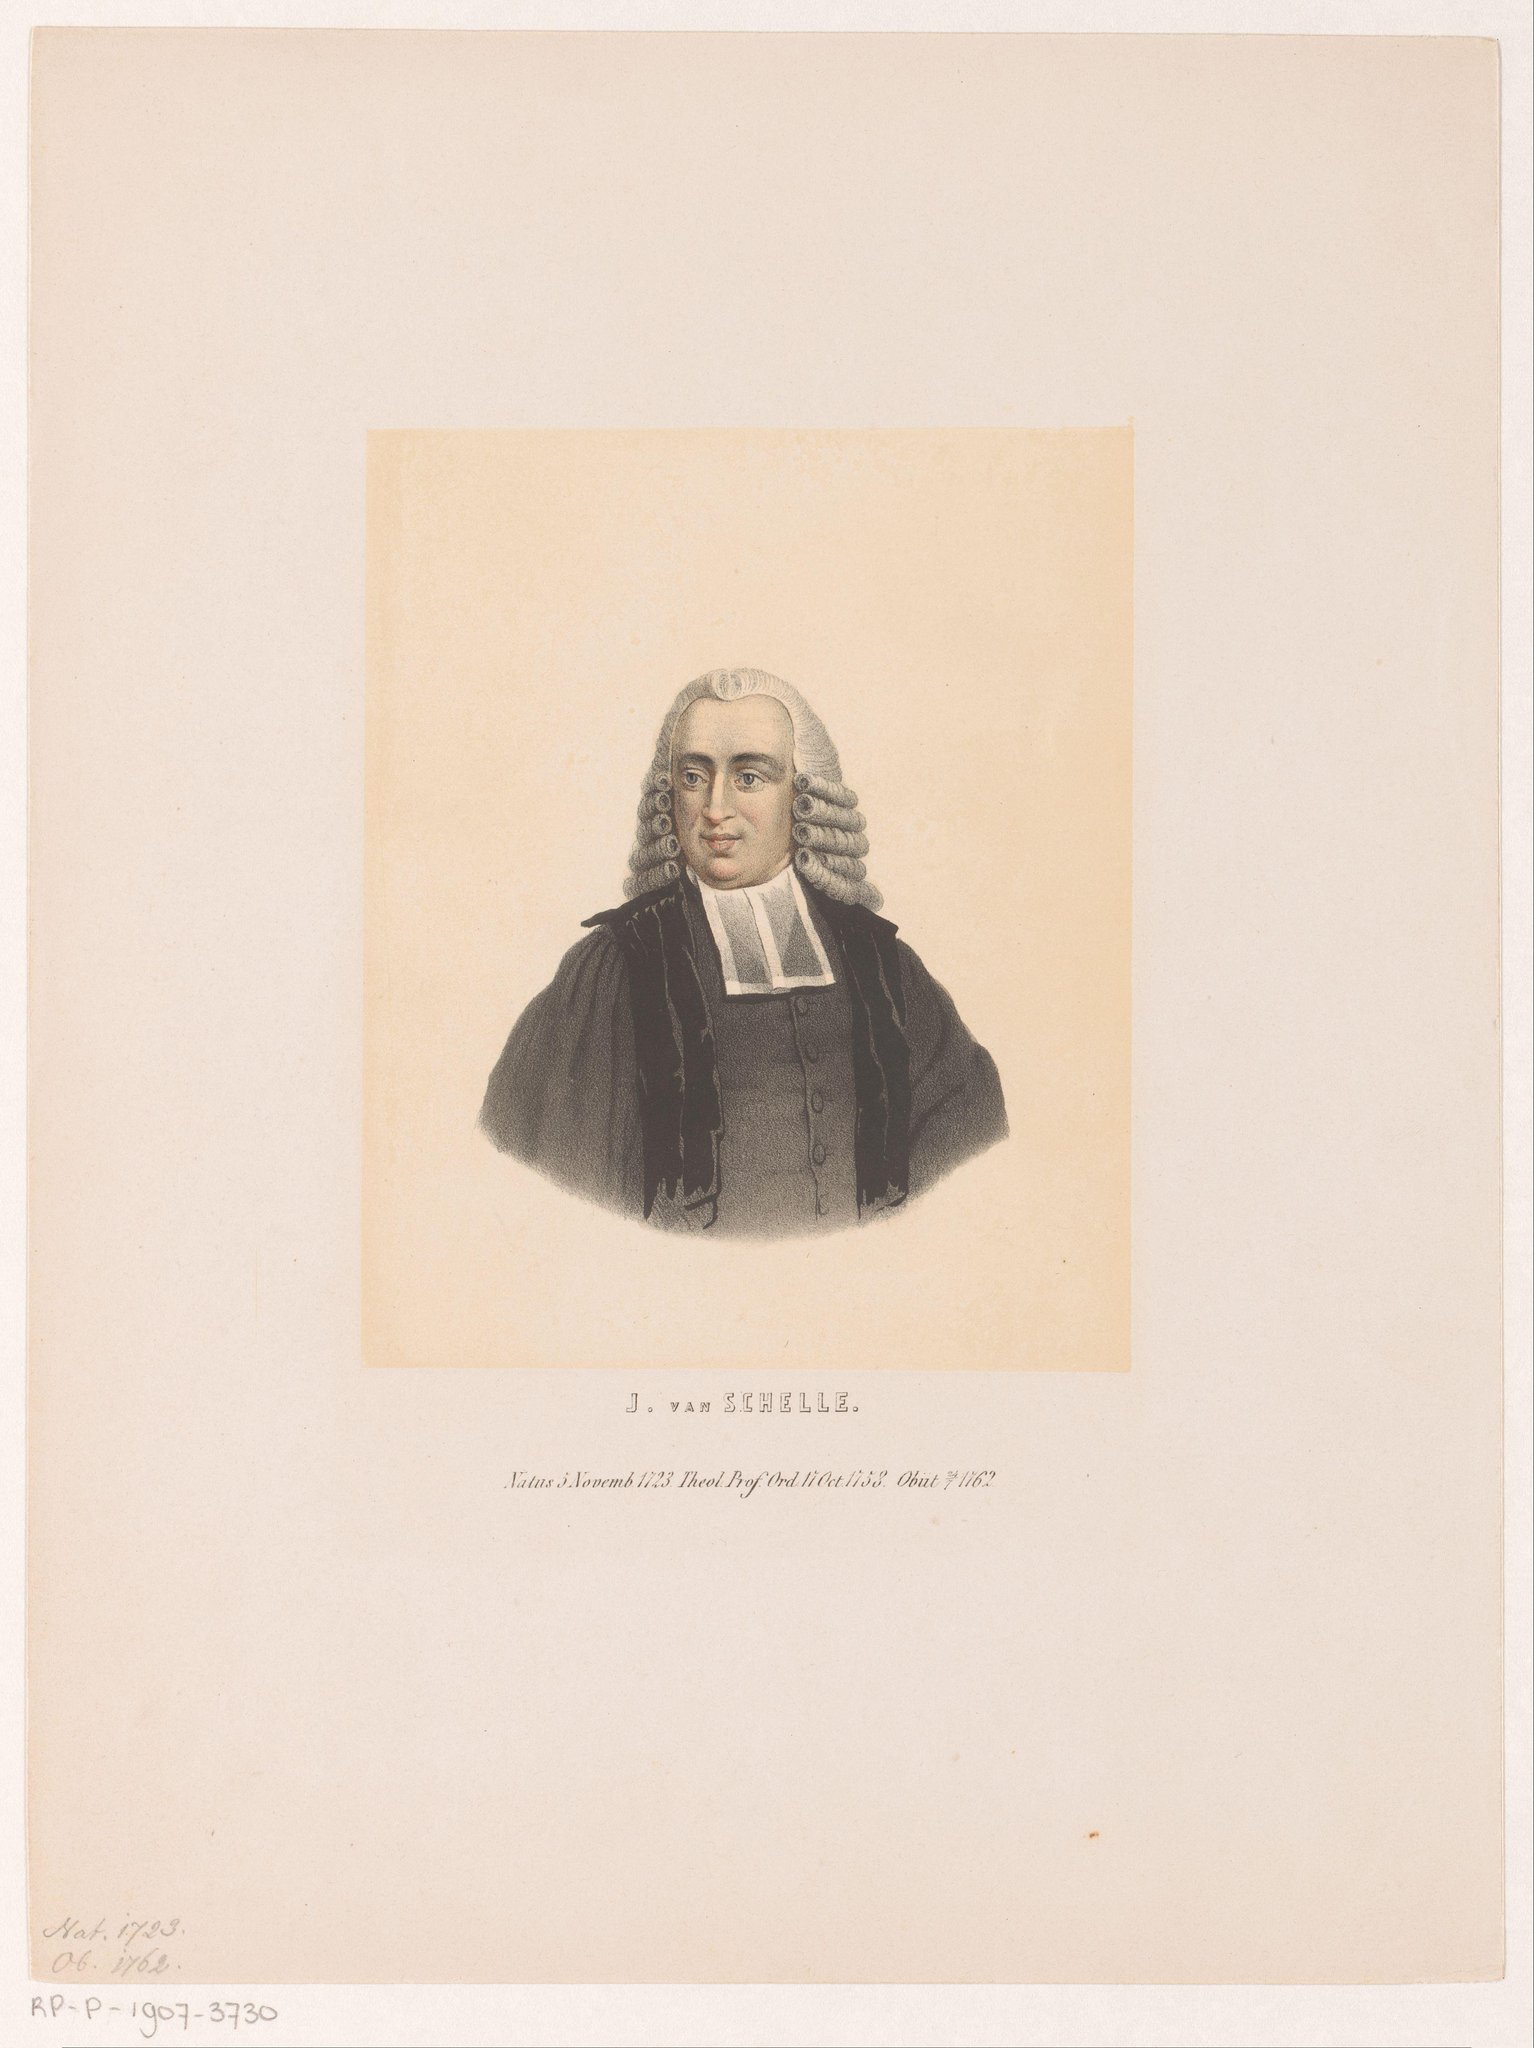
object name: print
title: Portret van Johannes van Schelle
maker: leendert springer (i)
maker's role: draughtsman, painter, print maker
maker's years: 1789-1871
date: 1850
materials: paper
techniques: lithograph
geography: leiden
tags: leiden, historical persons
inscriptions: collector's mark: Lugt 2228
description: Prent uit: Springer, Leendert. Galerij van hoogleeraren aan de Hoogeschool te Leijden, naar de oorspronkelijke afbeeldsels op de Senaat-zaal aldaar berustende. Leiden: Springer, Leendert., s.a. [circa 1850].